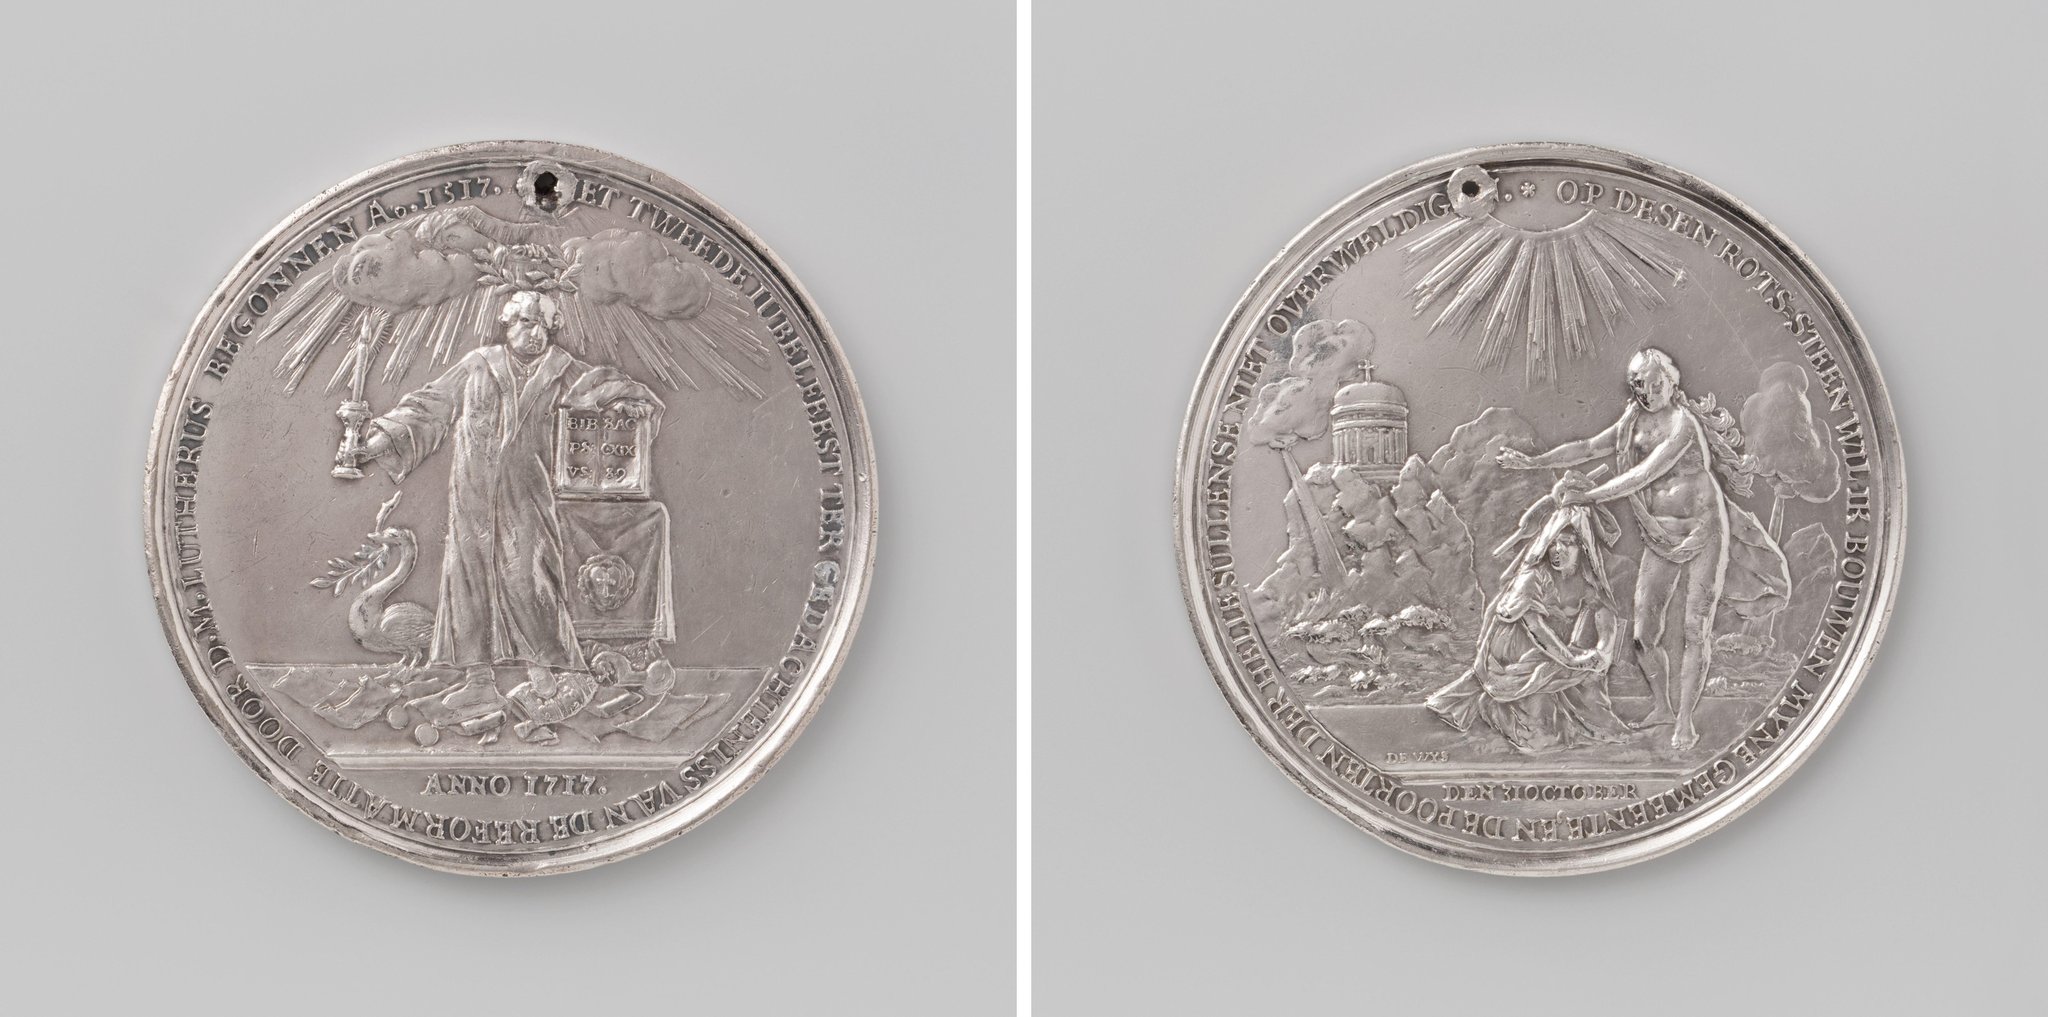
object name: history medal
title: Tweede eeuwfeest van de Reformatie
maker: willem de wijs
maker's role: medailleur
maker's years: 1700-1795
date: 1717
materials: silver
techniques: striking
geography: amsterdam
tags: martin luther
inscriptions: signature: ‘DE WYS’, caption: ‘DEN 31 OCTOBER’, caption: ‘ANNO 1717.’, circumscription: ‘HET TWEEDE IUBELFEEST TER GEDACHTENISS VAN DE REFORMATIE DOOR D.M. LUTHERUS, BEGONNEN Ao. 1517’, circumscription: ‘OP DESEN ROTS-STEEN WIL IK BOUWEN MYNE GEMEENTE, EN DE POORTEN DER HELLE SULLEN SE NIET OVERWELDIGEN’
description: Zilveren penning met gat. Voorzijde: Luther in priesterlijk gewaad met linkerhand op opengeslagen bijbel, die op altaar staat en met kandelaar in rechterhand vertrapt tiara en pauselijke bullen, links zwaan met olijftak in bek. Arm uit wolken houdt hem lauwerkrans boven hoofd, beschenen door zonnenstralen boven opschrift, binnen omschrift. Keerzijde: beschenen door hemellicht helpt Waarheid Mensheid, afgebeeld als knielende, gesluierde vrouw onder juk van het katholieke geloof uit. Op achtergrond tempel op rots, waartegen door stormwind opgezweepte golven beuken boven opschrift, binnen omschrift.